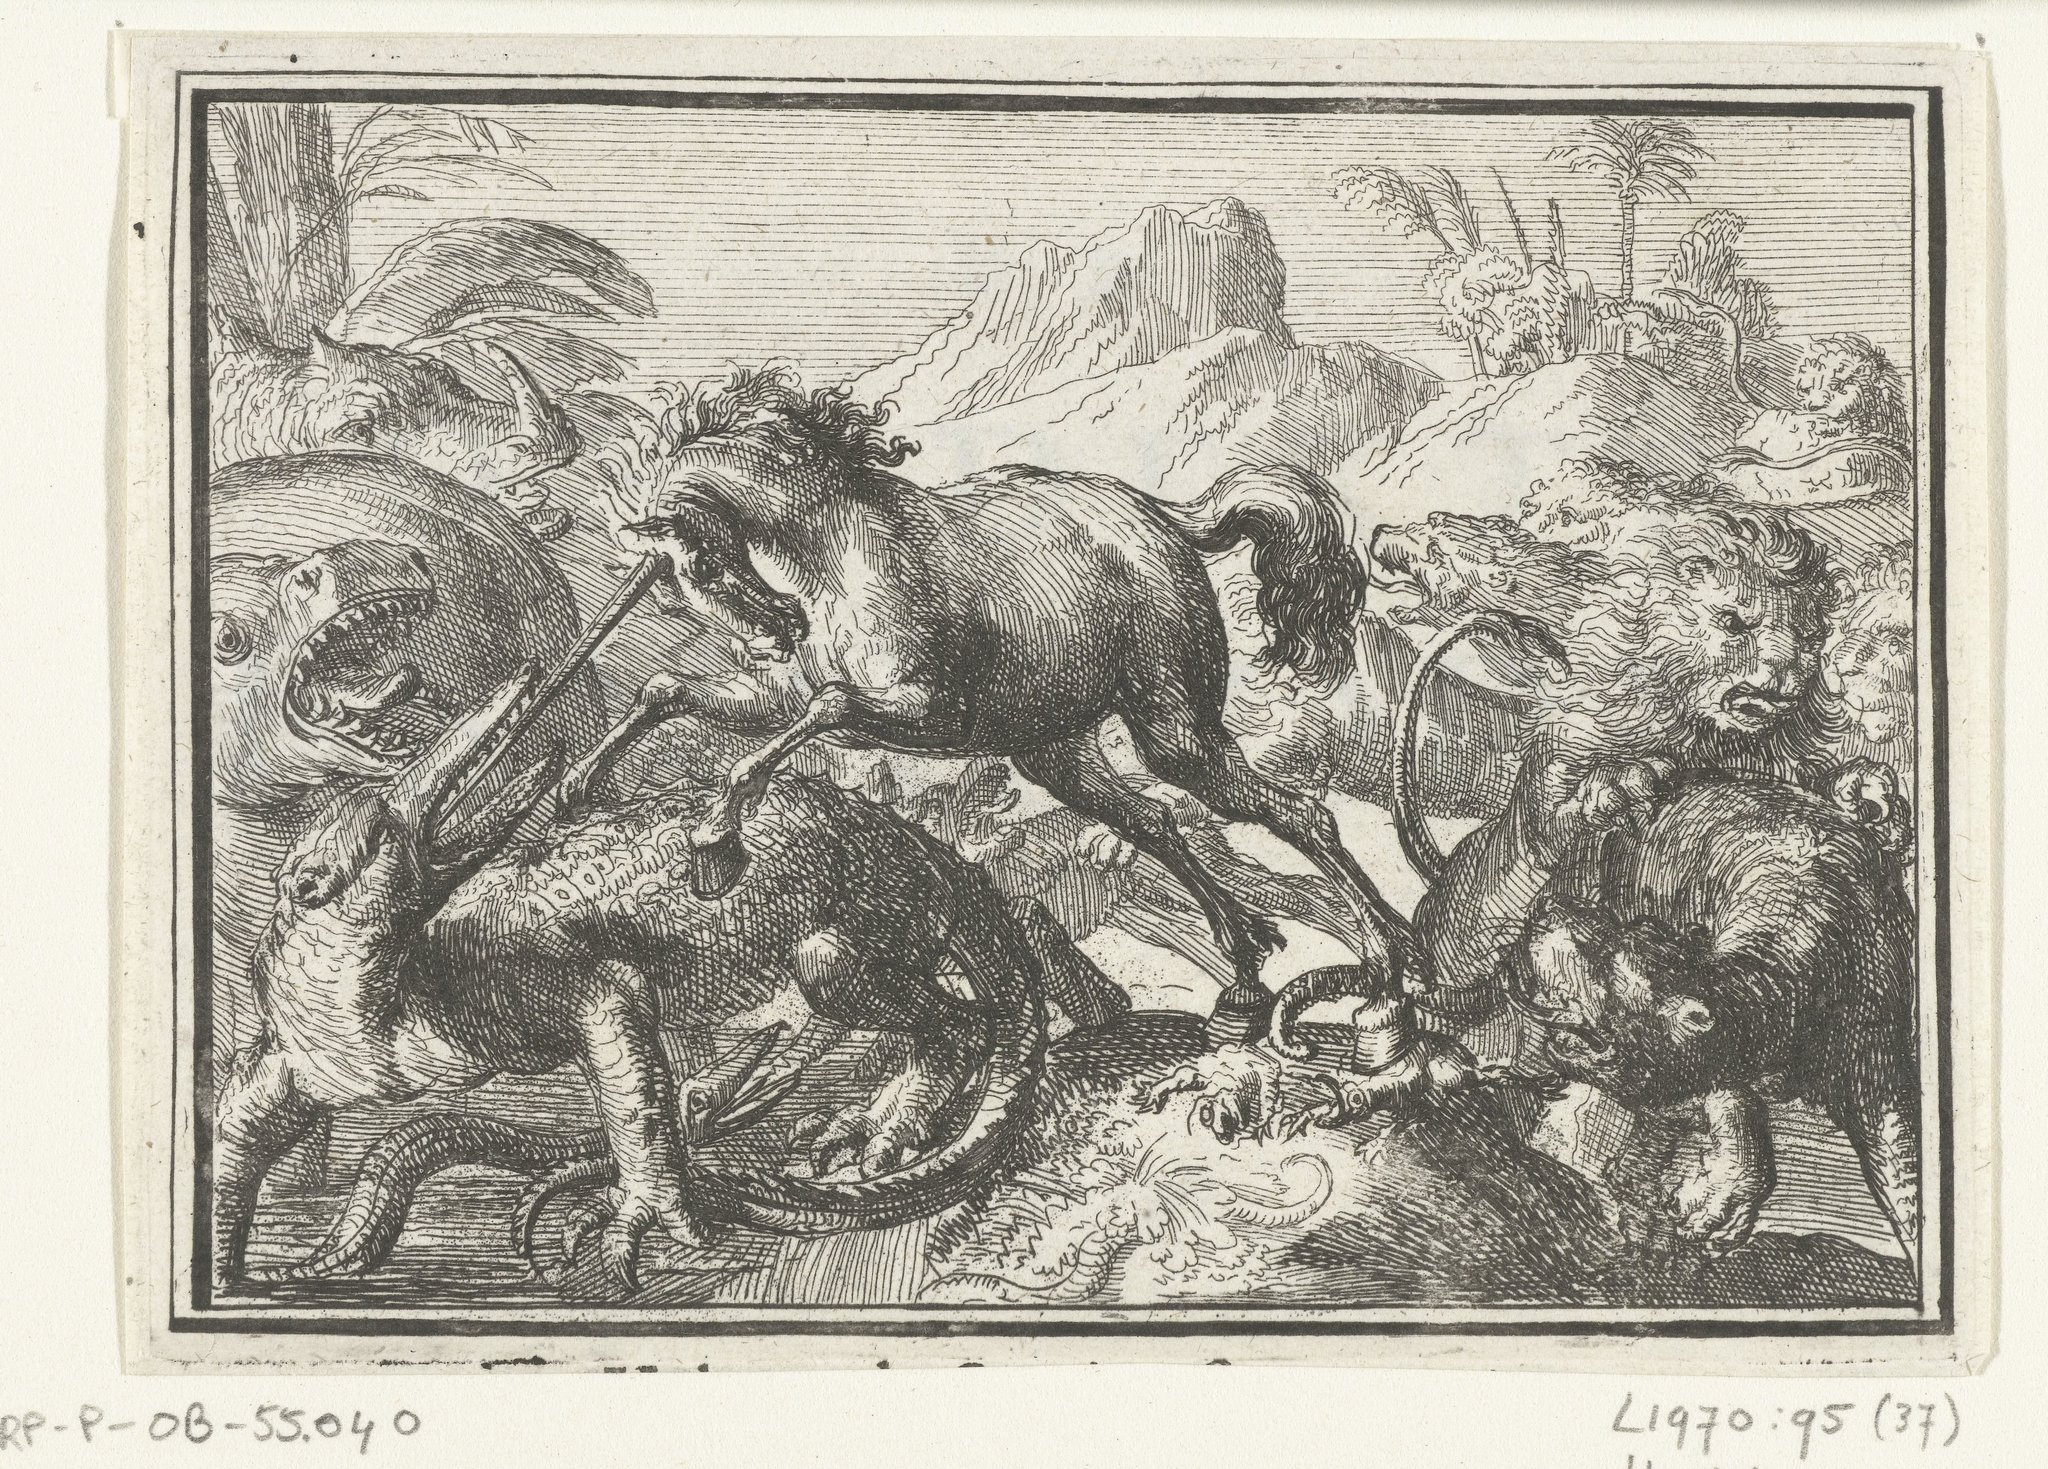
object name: print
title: Titelblad voor het pamflet: De Ontdekte Eenhoorn, 1701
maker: romeyn de hooghe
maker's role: draughtsman, goldsmith, painter, print maker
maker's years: 1645-1708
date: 1702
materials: paper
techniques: engraving, etching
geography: netherlands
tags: anna stuart (koningin van engeland en schotland)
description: De eenhoorn (Engeland onder koningin Anna) en leeuwen (Geallieerden) strijden samen tegen de tijger (Frankrijk) en andere dieren, waaronder een nijlpaard, krokodil en neushoorn. Titel staat op apart tekstblad